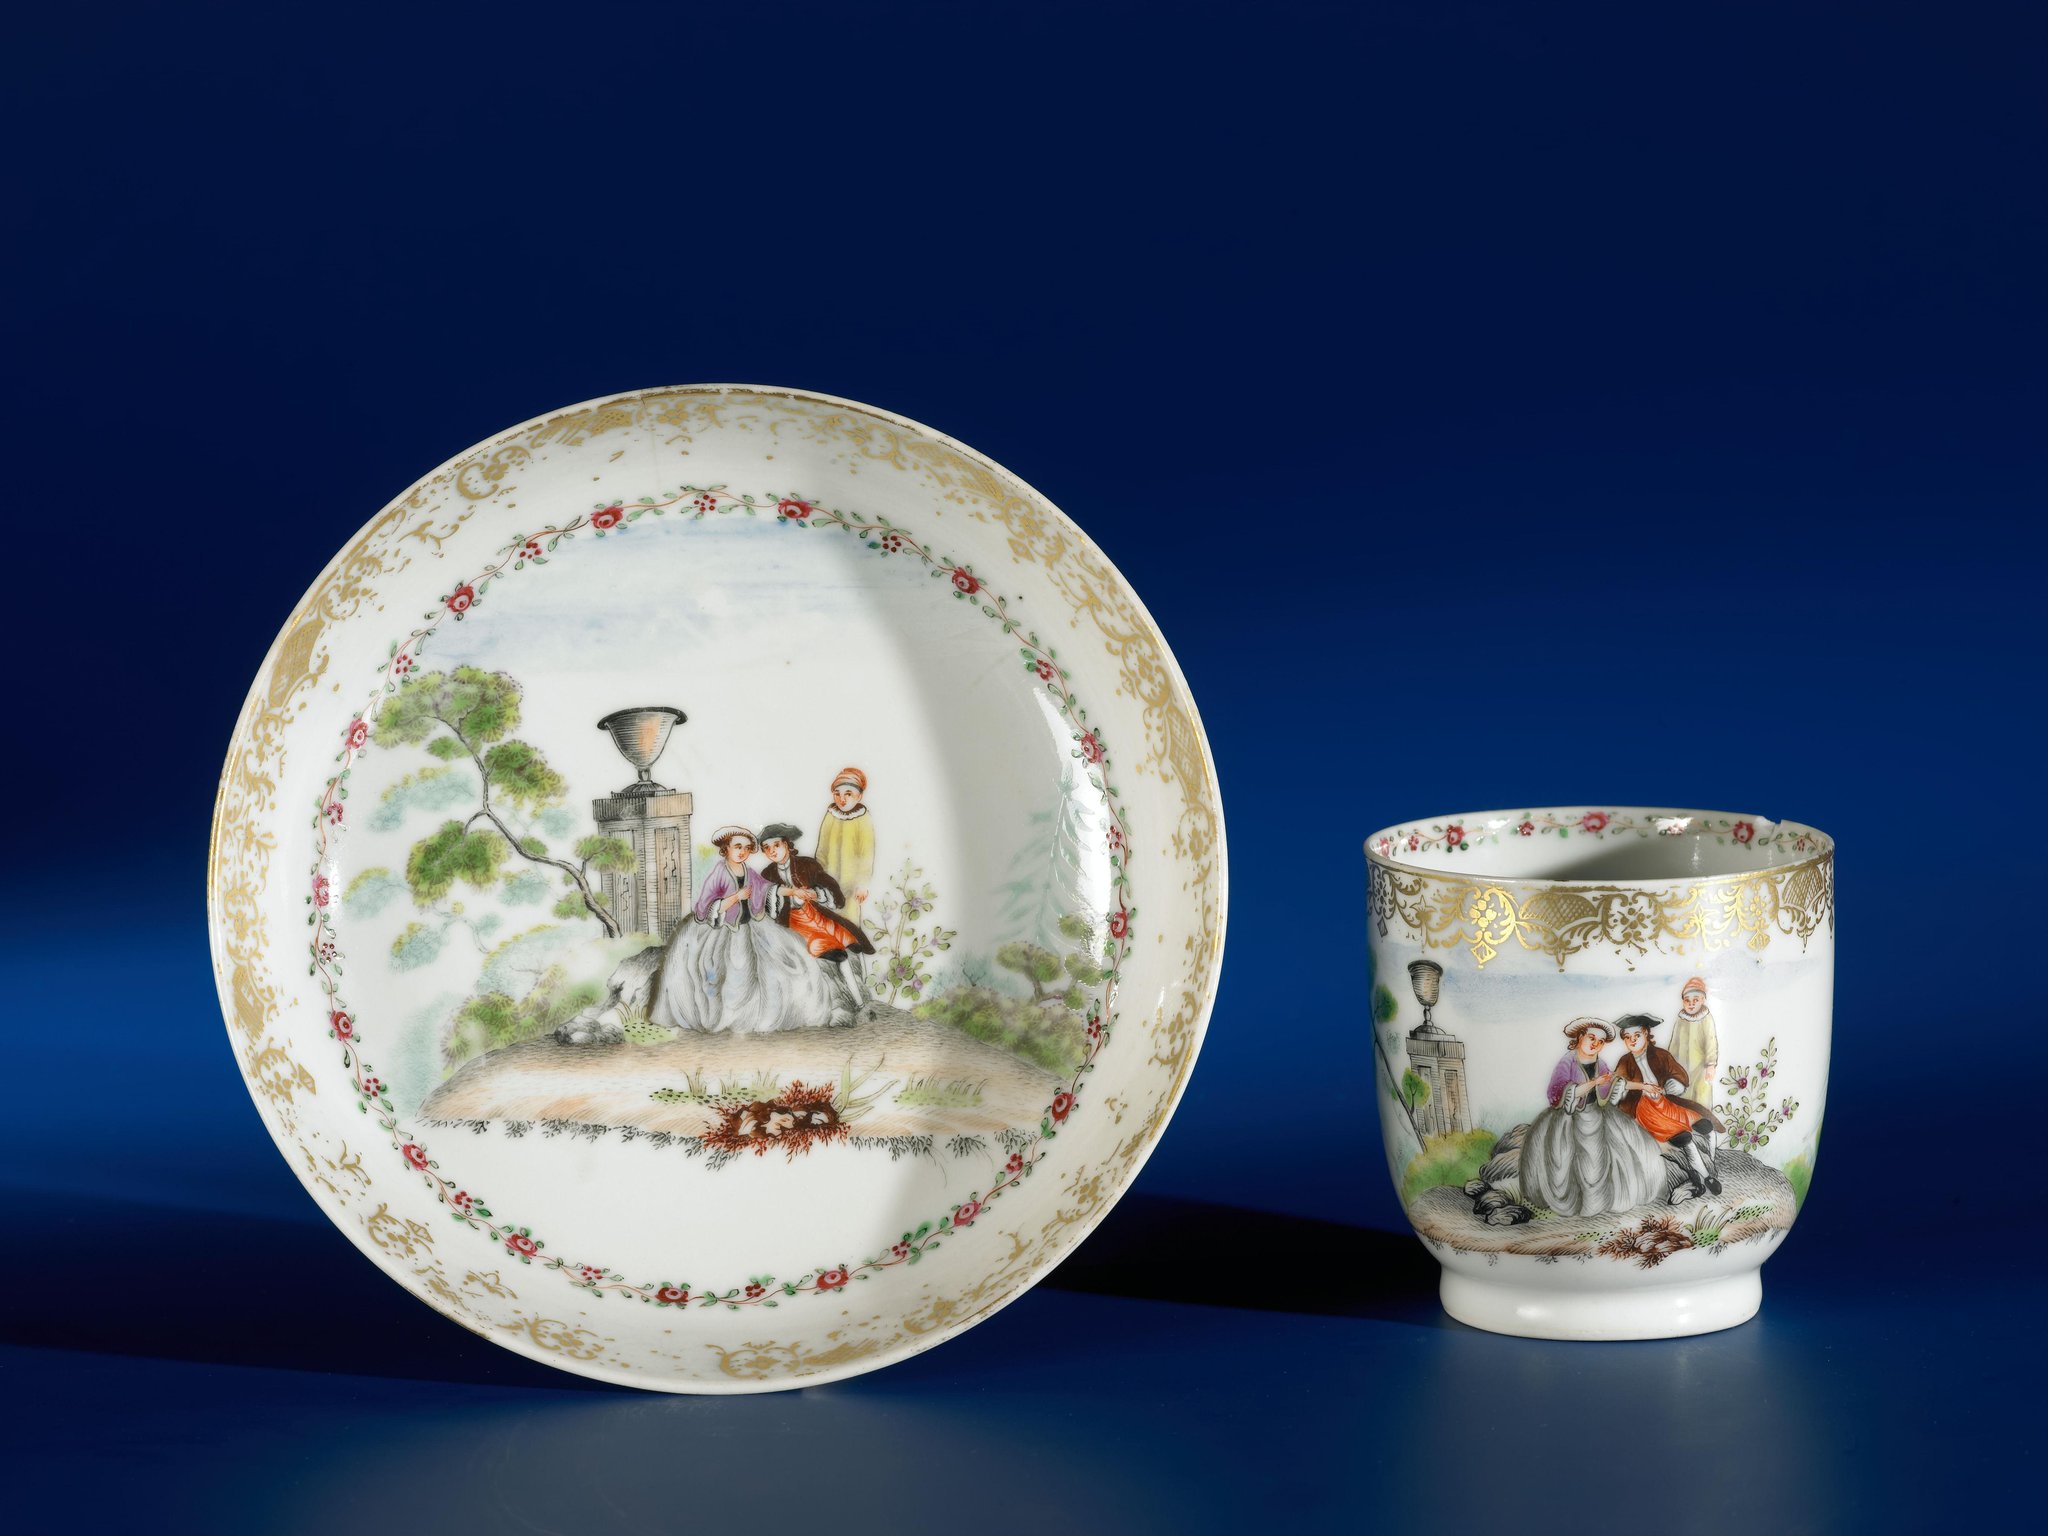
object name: cup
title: Cup with handle with an European couple sitting in a landscape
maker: Anonymous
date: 1775-1799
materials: glaze, gold, paint, porcelain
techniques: firing, gilding, turning, vitrification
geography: china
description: Oorkop van porselein, beschilderd op het glazuur in blauw, rood, roze, groen, geel, paars, zwart en goud. Op de wand een medaillon van bloemranken met hierin een voorstelling van een zittend Europees paar in een landschap. Zij worden gadegeslagen door een derde persoon achter hun, die doet denken aan een personage uit de Commedia dell'Arte. Achter het paar een vaas op een sokkel. Een barst in de wand van de kop. Europese voorstelling in emailkleuren.